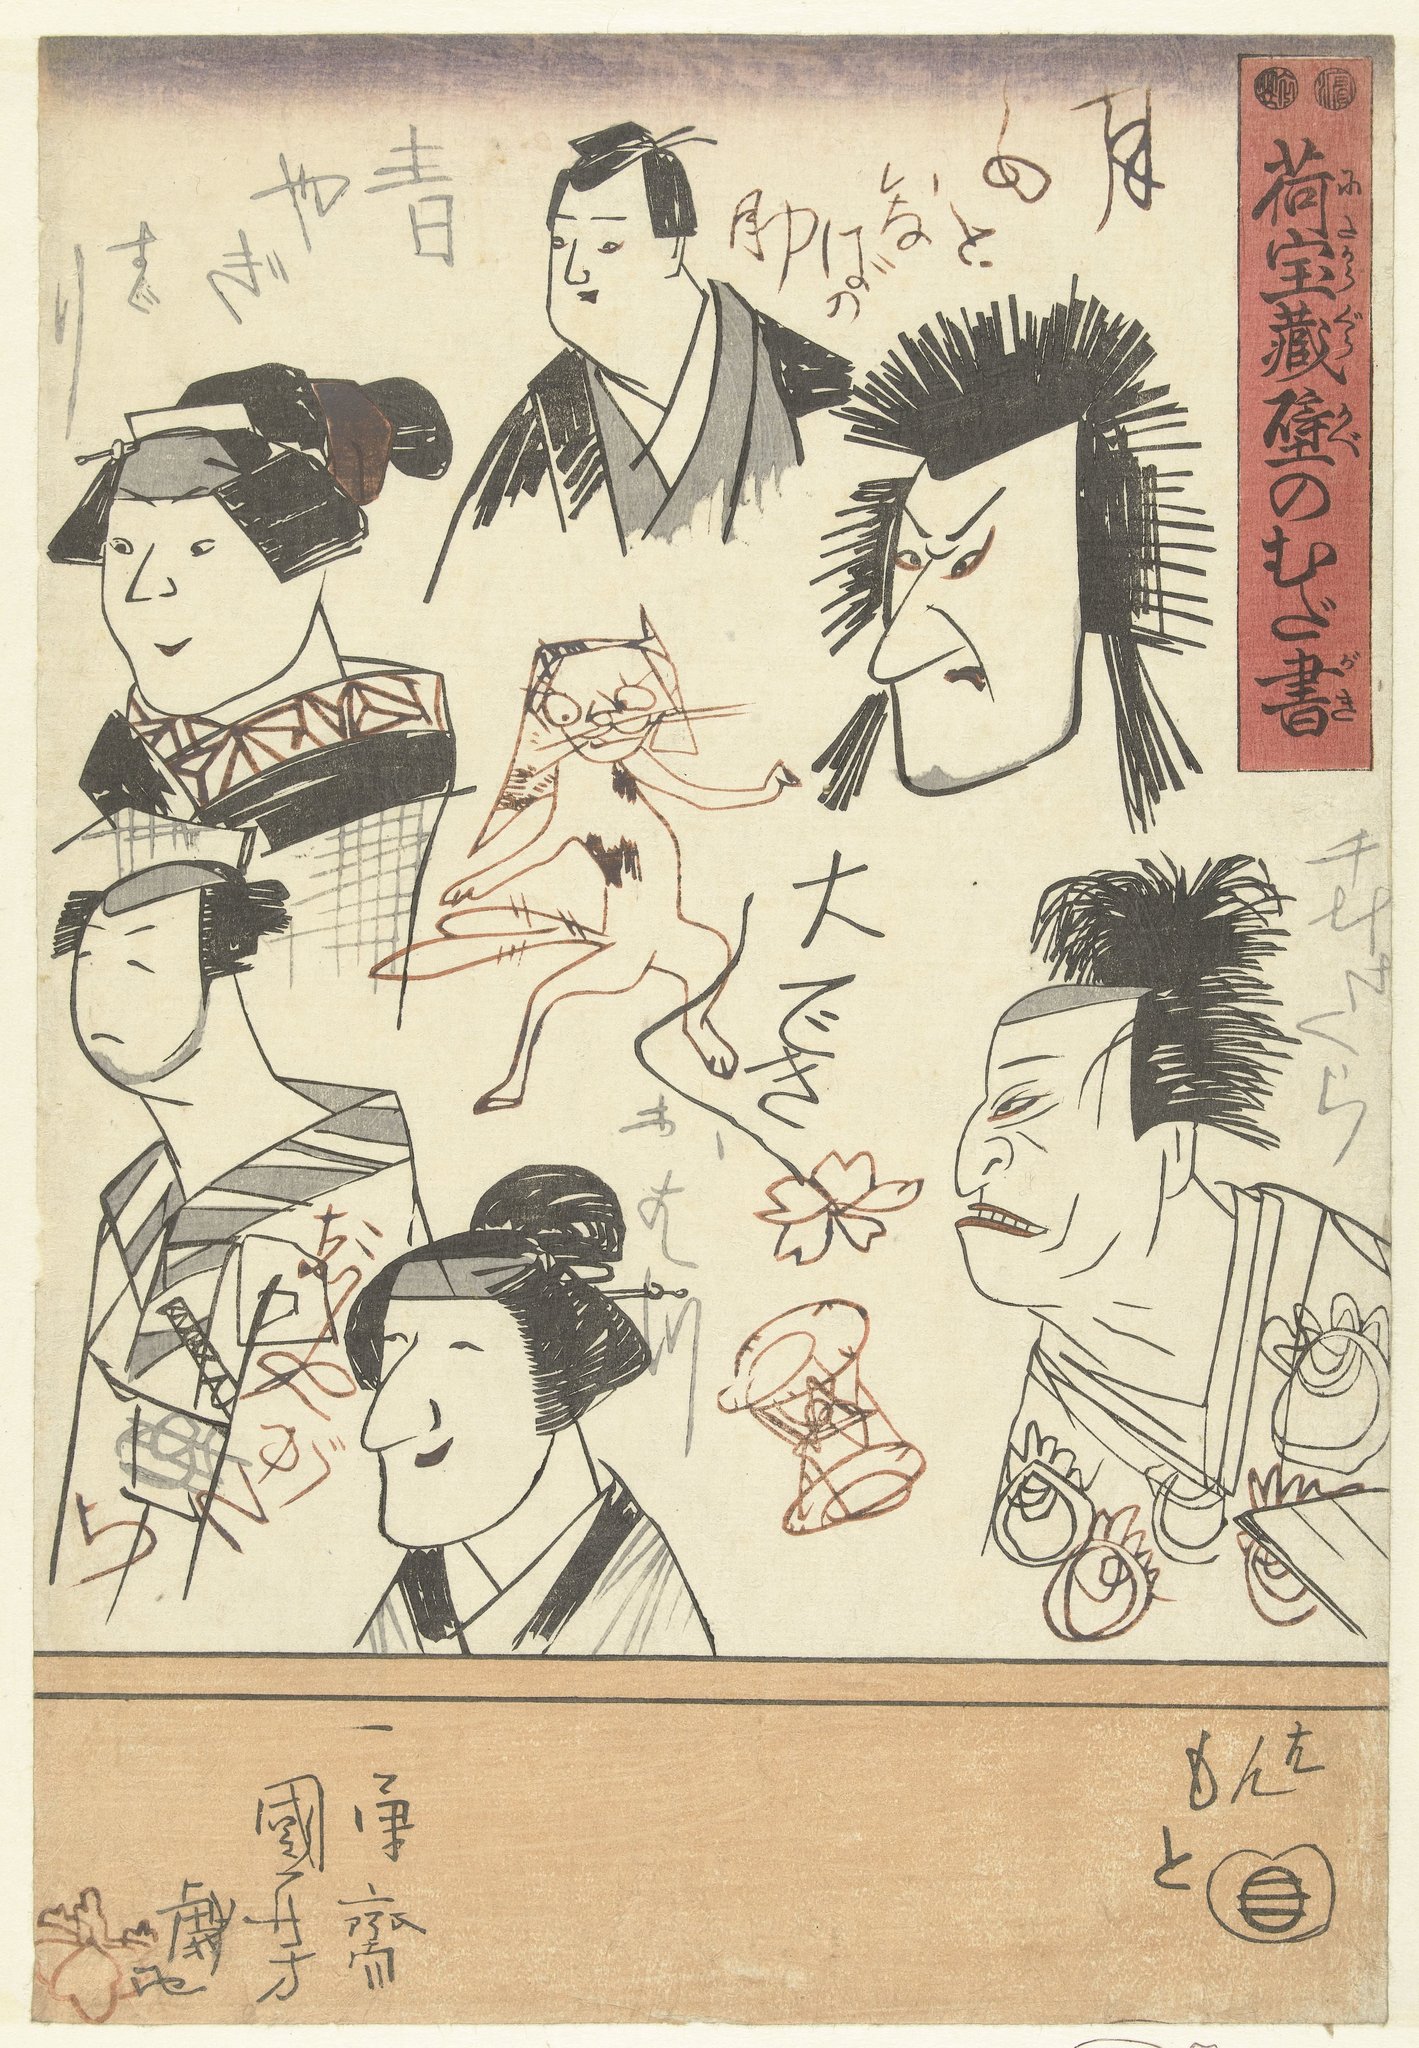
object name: print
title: Zes acteursportretten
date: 1847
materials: paper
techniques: woodcut, nishiki e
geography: japan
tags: drawing, sketch, cat, portrait of actor, actress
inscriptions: collector's mark: Lugt 2228, collector's mark: Lugt 2760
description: Wand waarop graffiti voorstellende zes acteursportretten, een kat en een handtrommel.